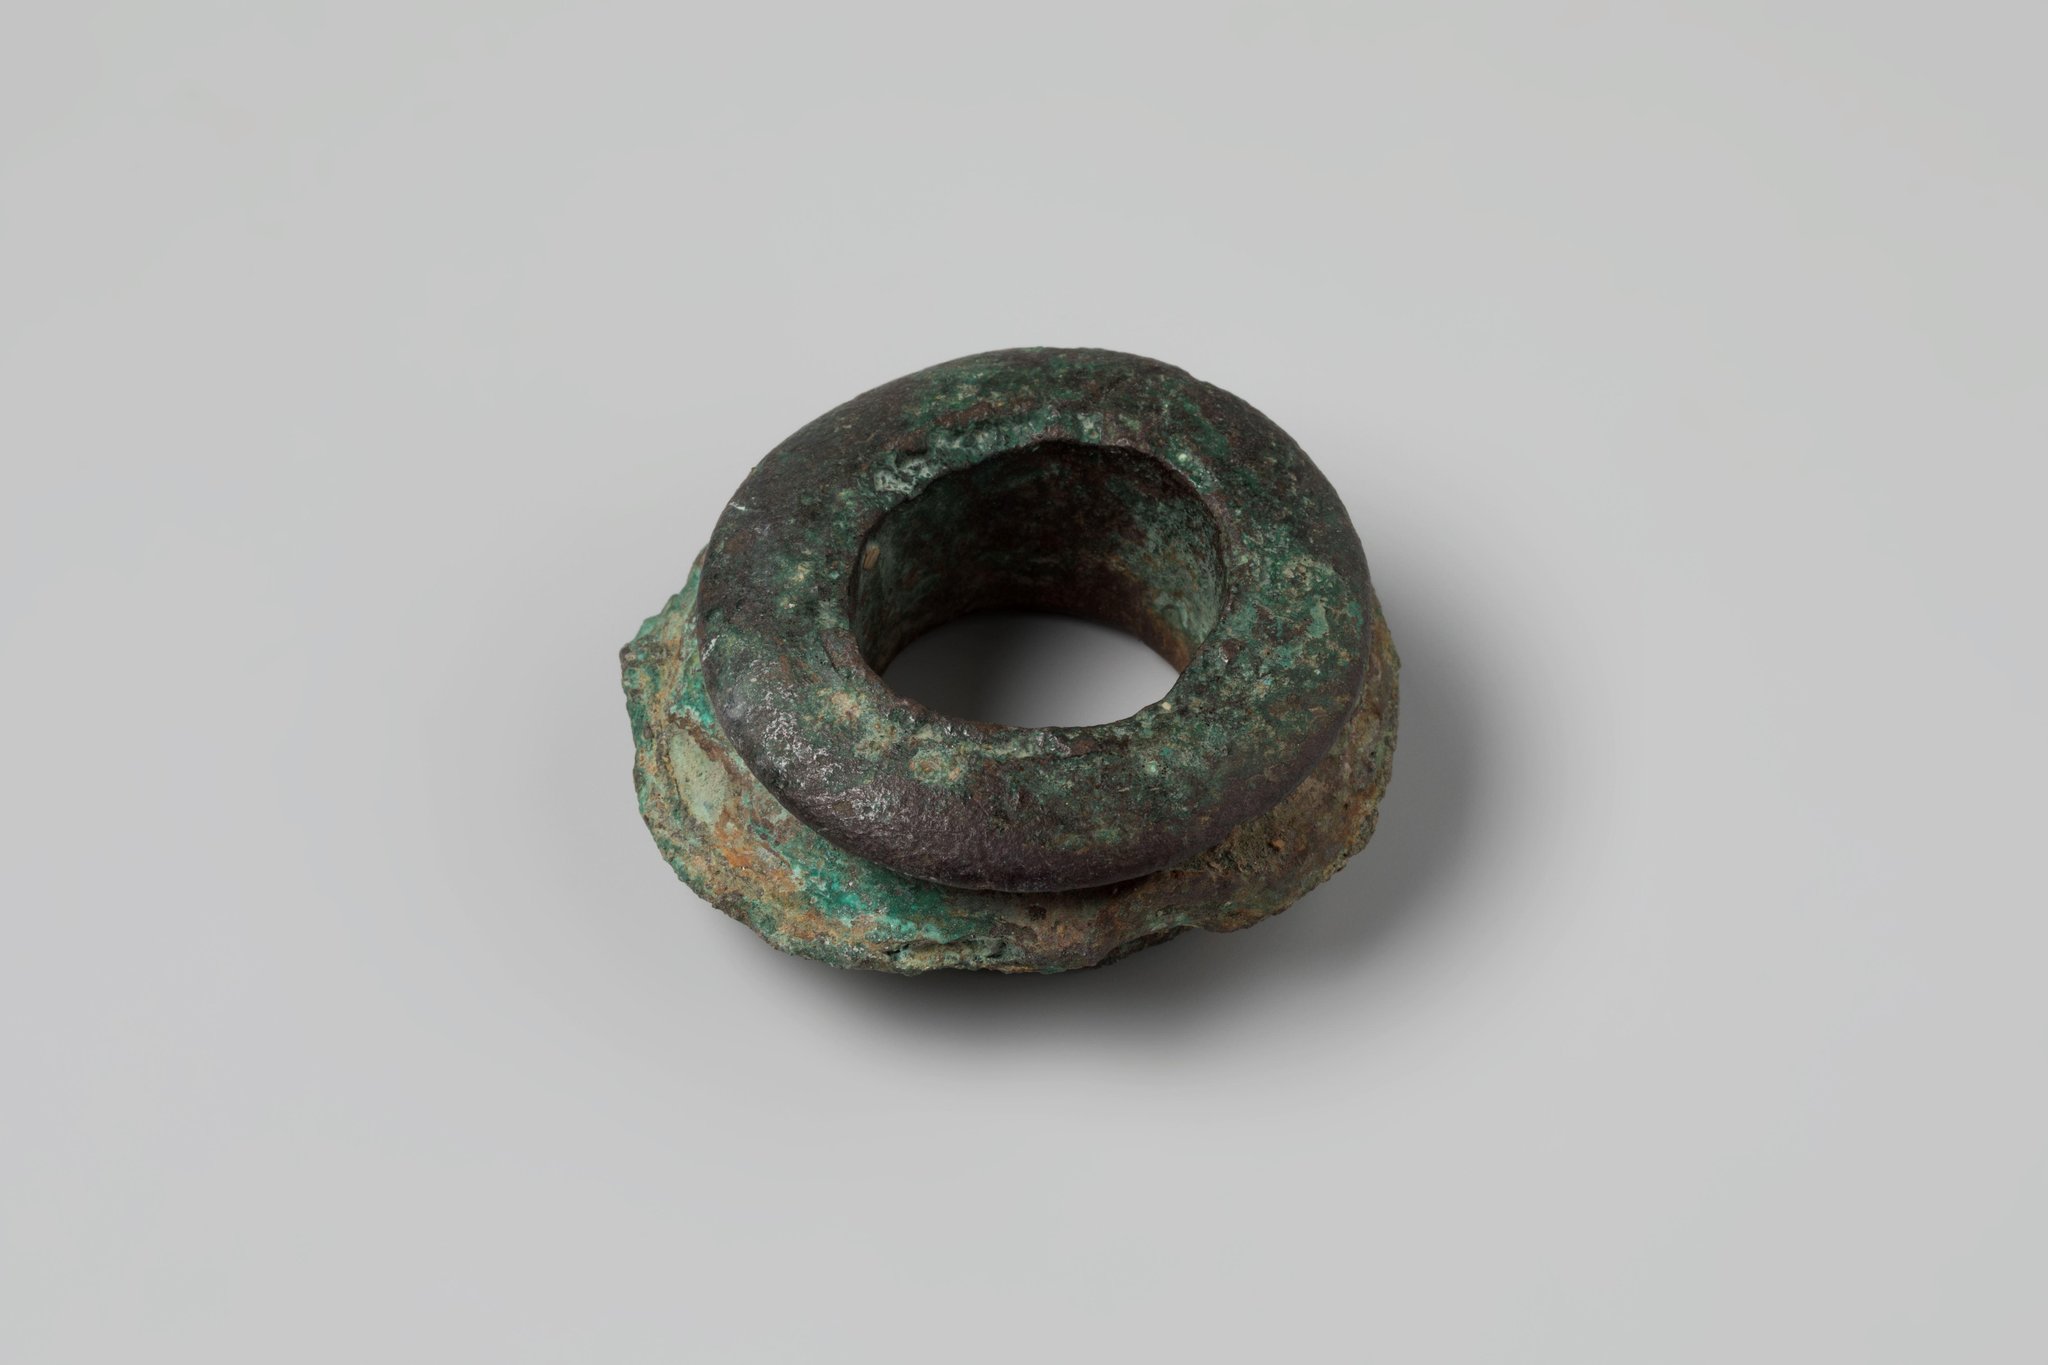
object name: fastening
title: Sluiting van koper; uit het wrak de Oost-Indiëvaarder Hollandia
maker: Anonymous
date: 1700-1743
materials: copper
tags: verenigde oostindische compagnie, hollandia (schip)